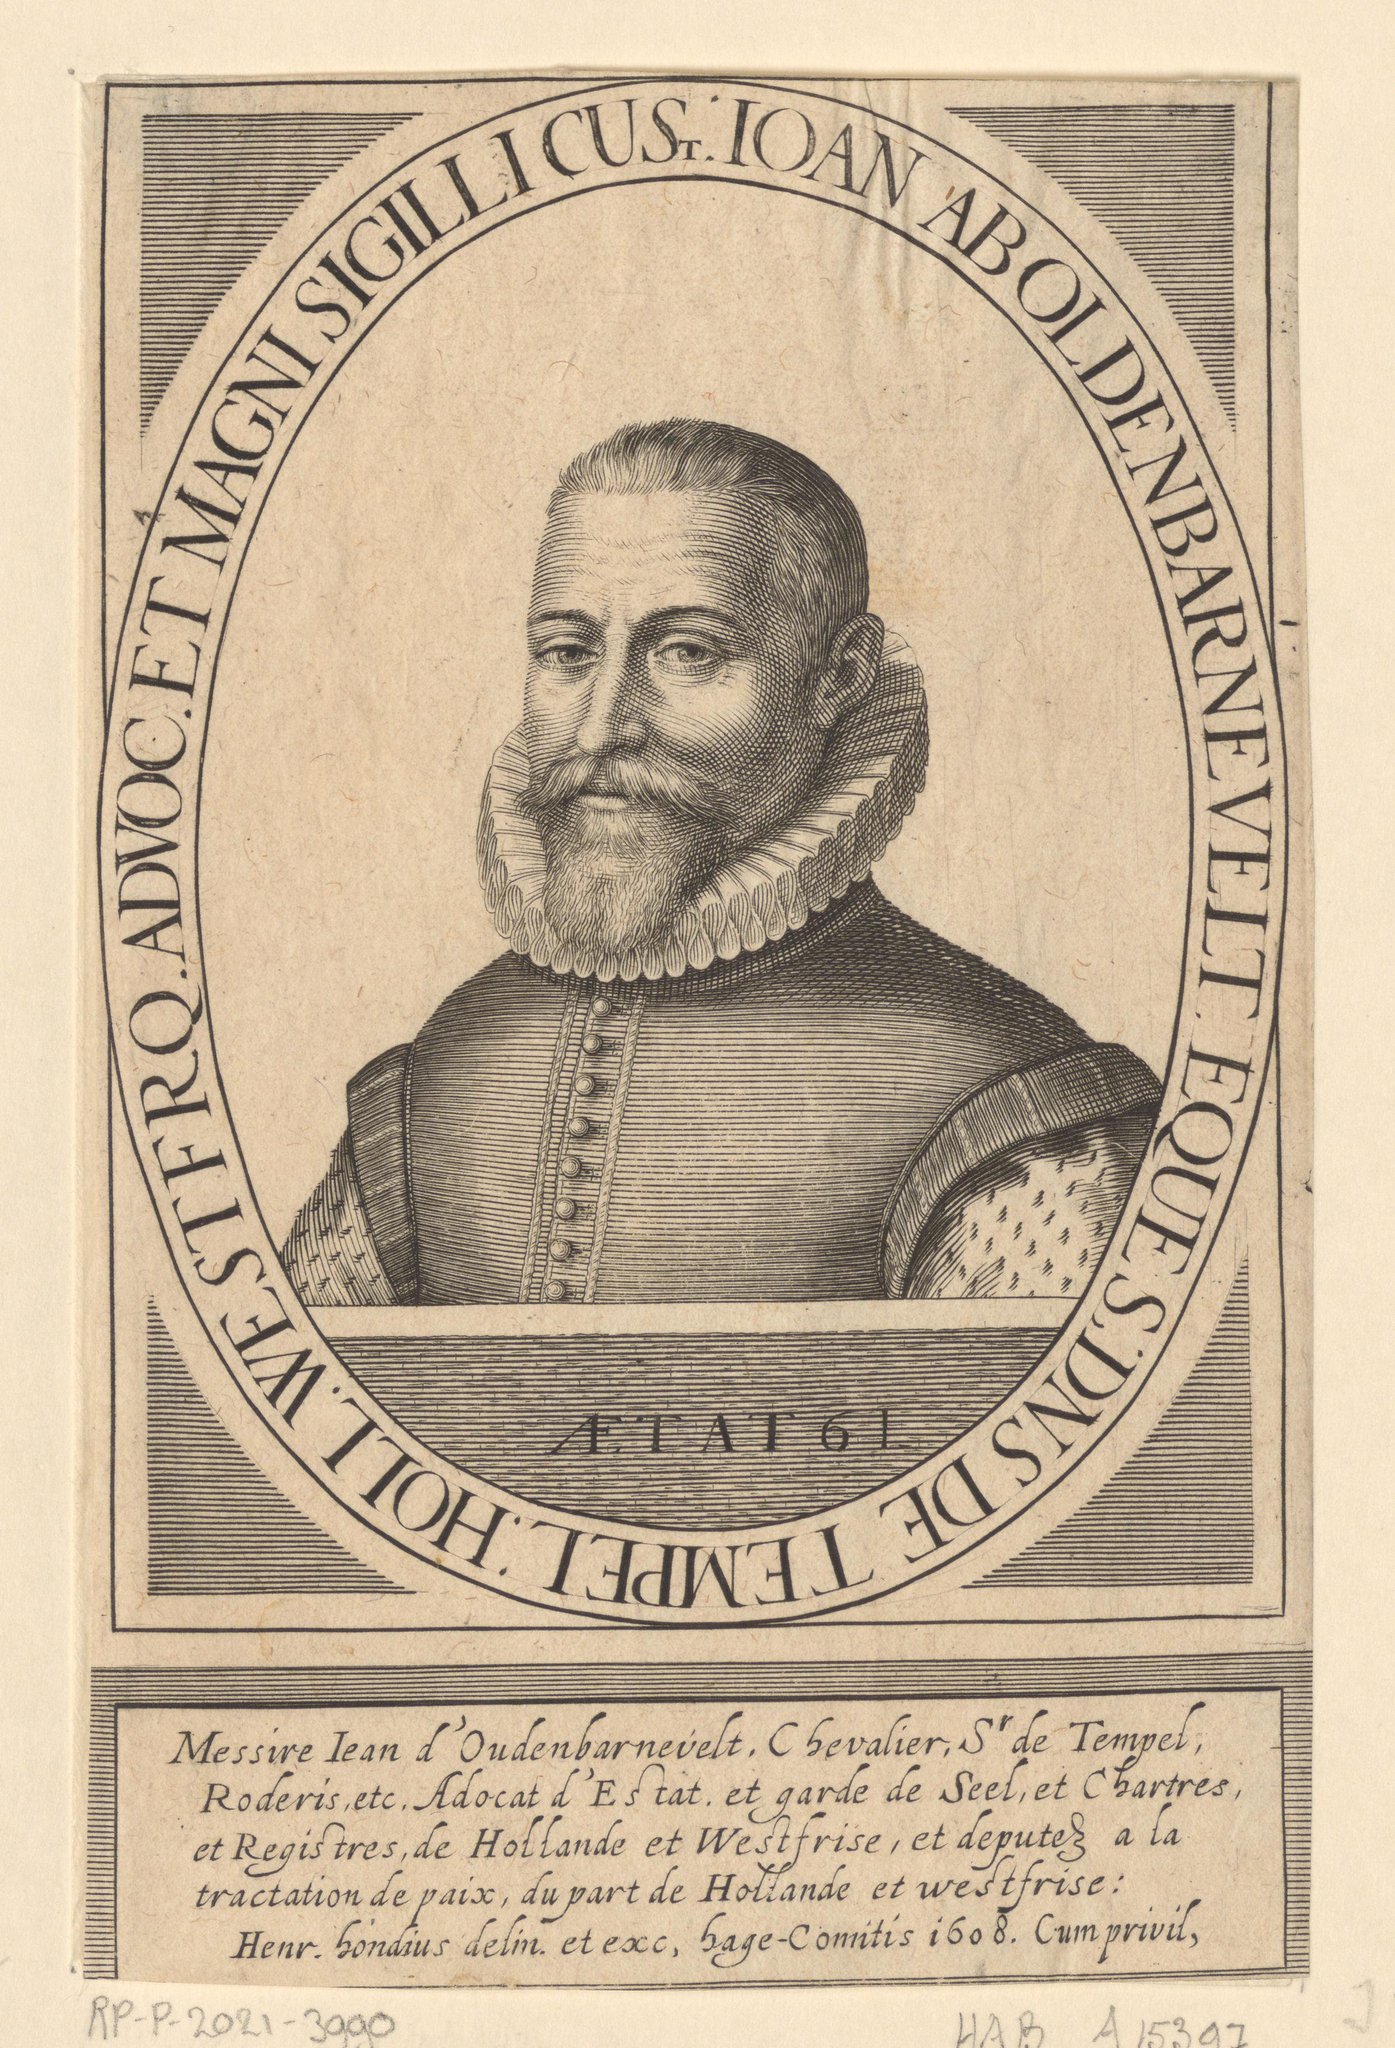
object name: print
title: Belgiae Pacificatorum Vera Delineatio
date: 1608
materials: paper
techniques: engraving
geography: the hague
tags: the hague, johan van oldenbarnevelt, historical persons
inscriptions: collector's mark: Lugt 2228